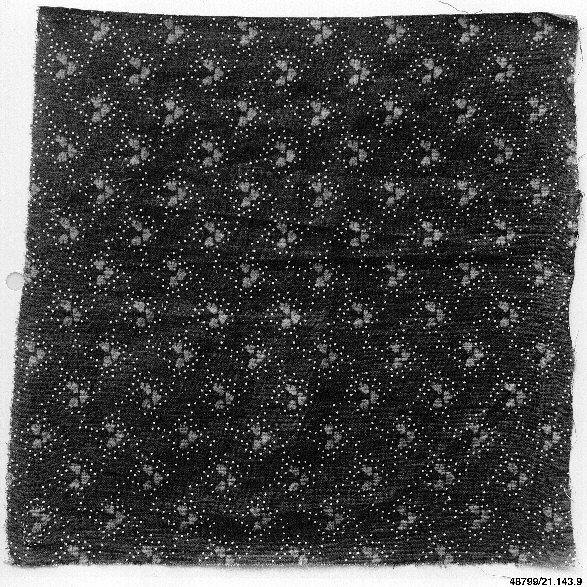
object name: textile fragment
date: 1801-1900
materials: cotton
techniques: printing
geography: india